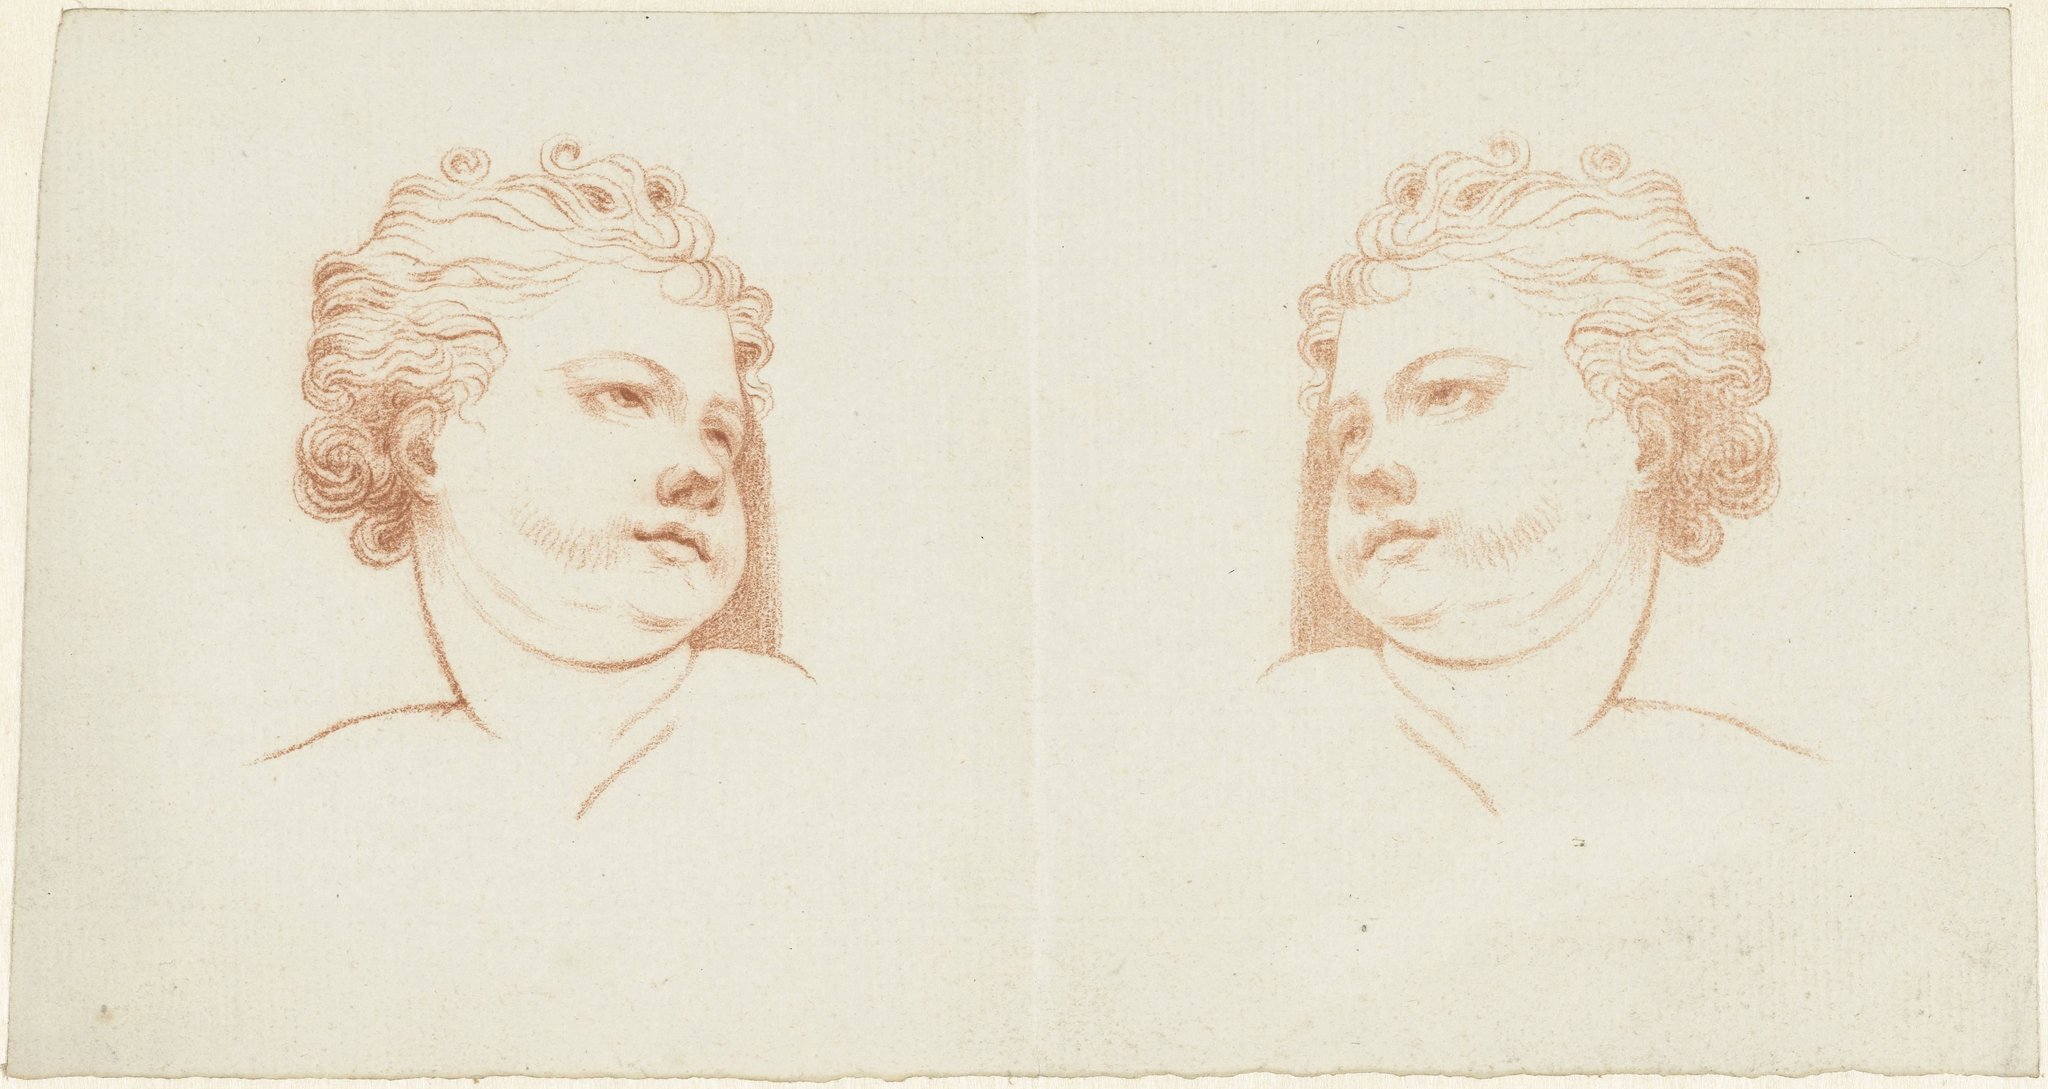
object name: drawing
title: Kinderkopje met tegendruk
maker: jordanus hoorn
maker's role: draughtsman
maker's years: 1753-1833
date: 1763-1833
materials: chalk, paper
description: Kinderkopje, met de tegendruk op hetzelfde blad.